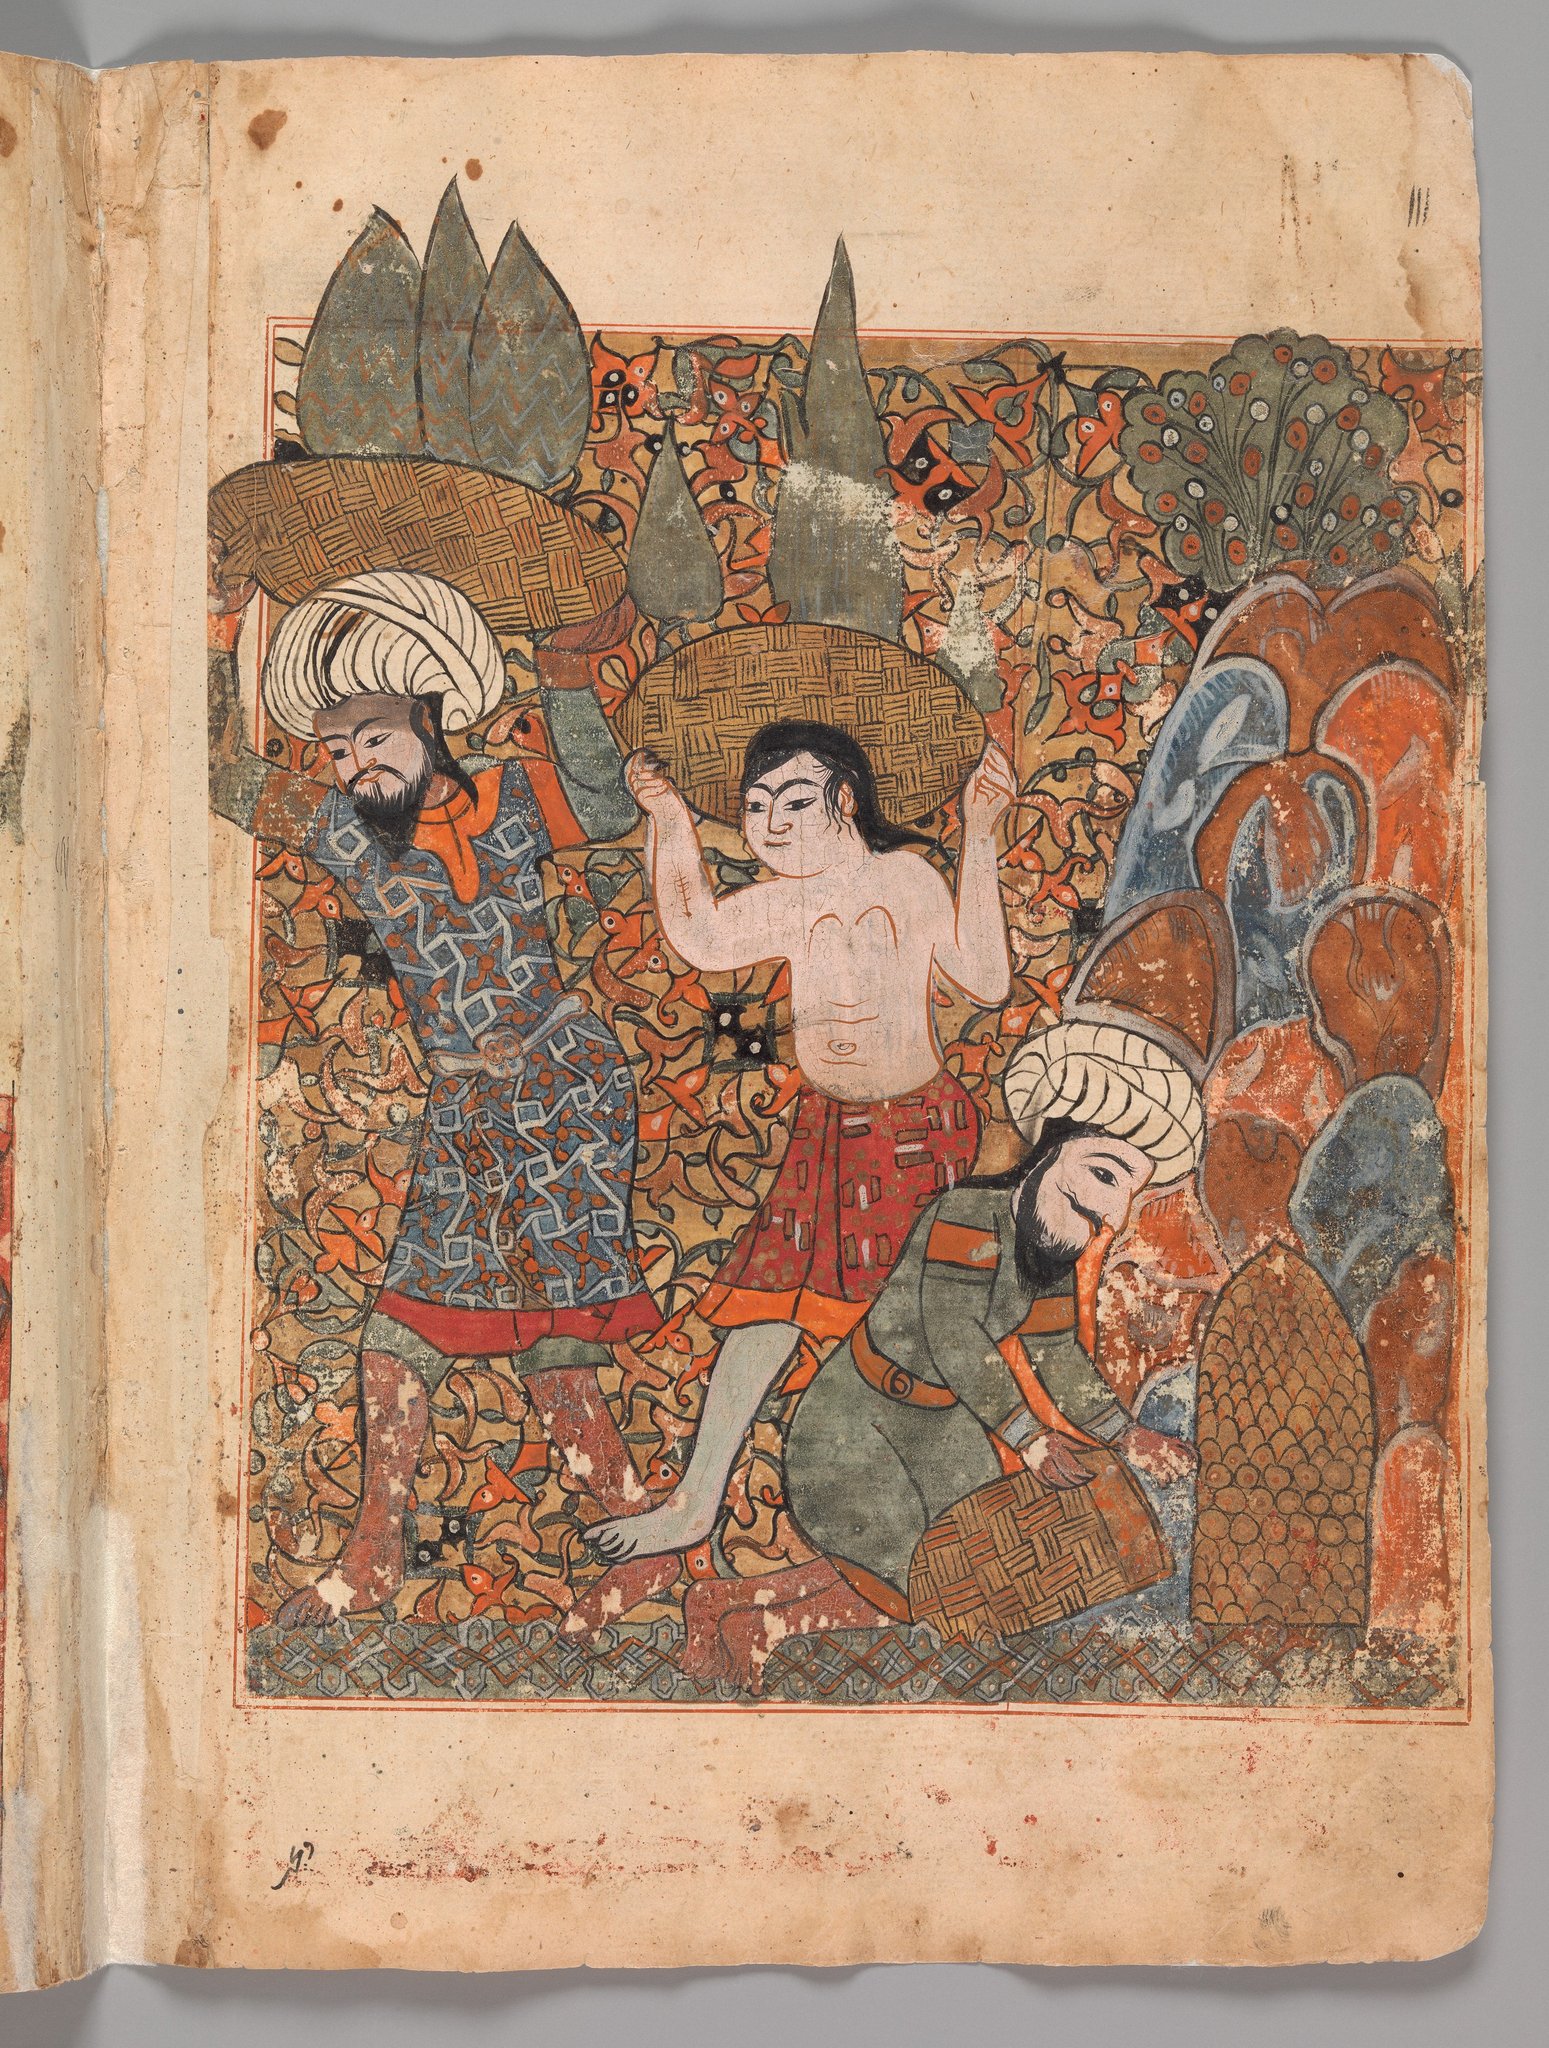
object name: folio from an illustrated manuscript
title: "The Man who Discovers the Treasure has it Carried Away by Hired Workmen", Folio from a Kalila wa Dimna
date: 1526-1550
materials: ink, paper, watercolor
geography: india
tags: men,working